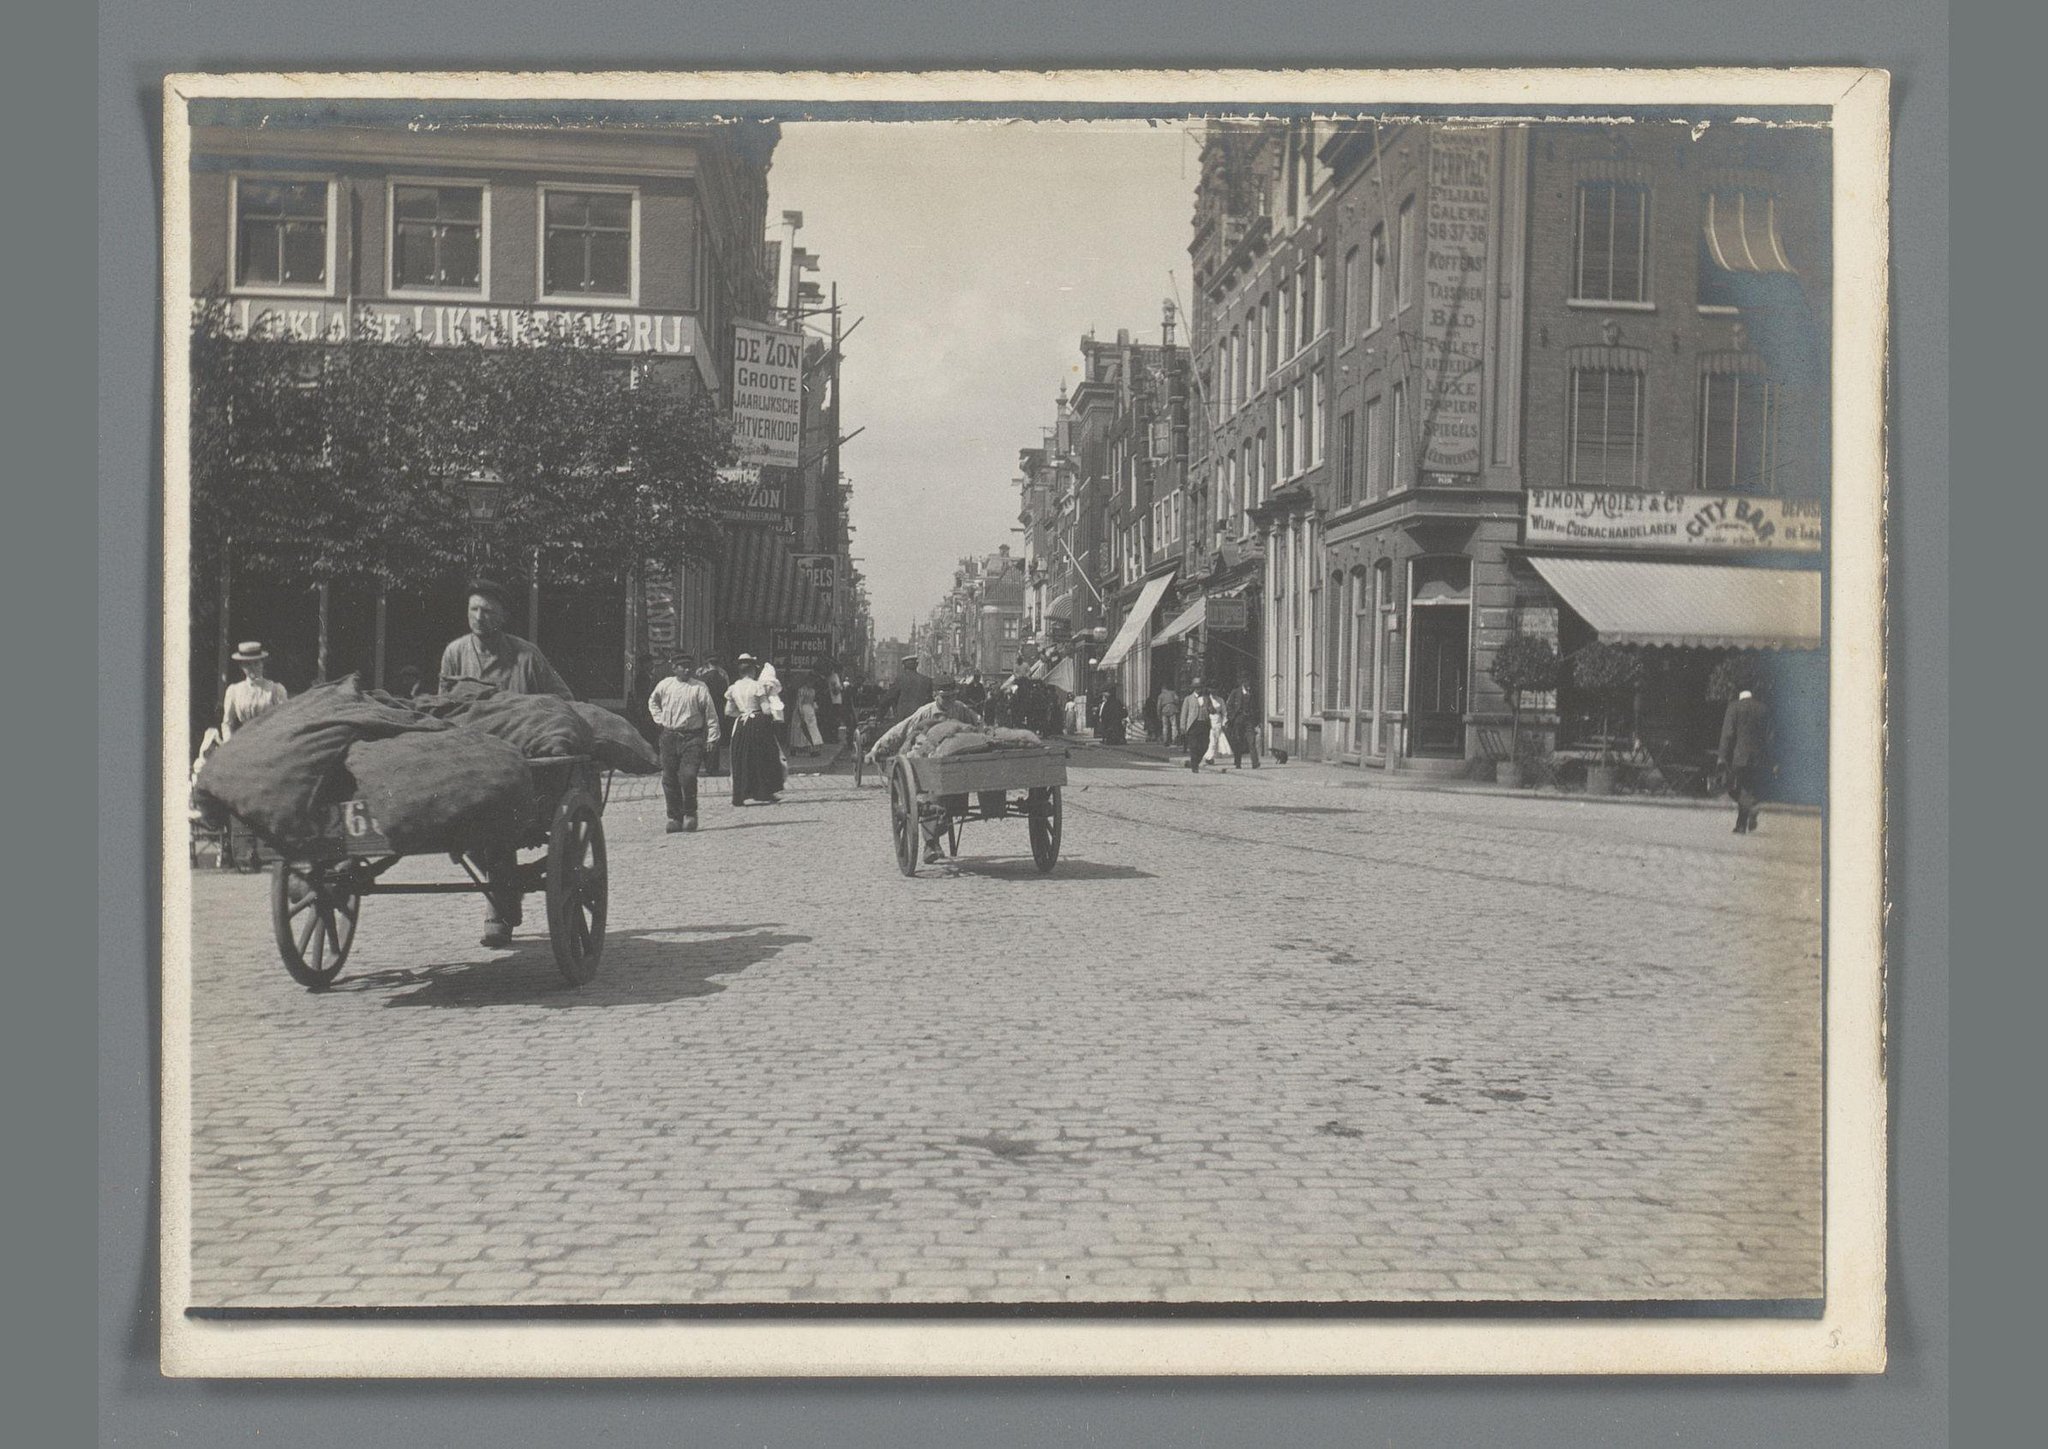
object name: photograph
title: Leidseplein met passanten en karren, Amsterdam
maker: willem de jong (fotograaf)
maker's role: arts, fotograaf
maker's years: 1864-1918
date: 1895-1918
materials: paper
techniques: gelatin silver print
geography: amsterdam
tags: hand-cart, square, place, circus, etc., walking